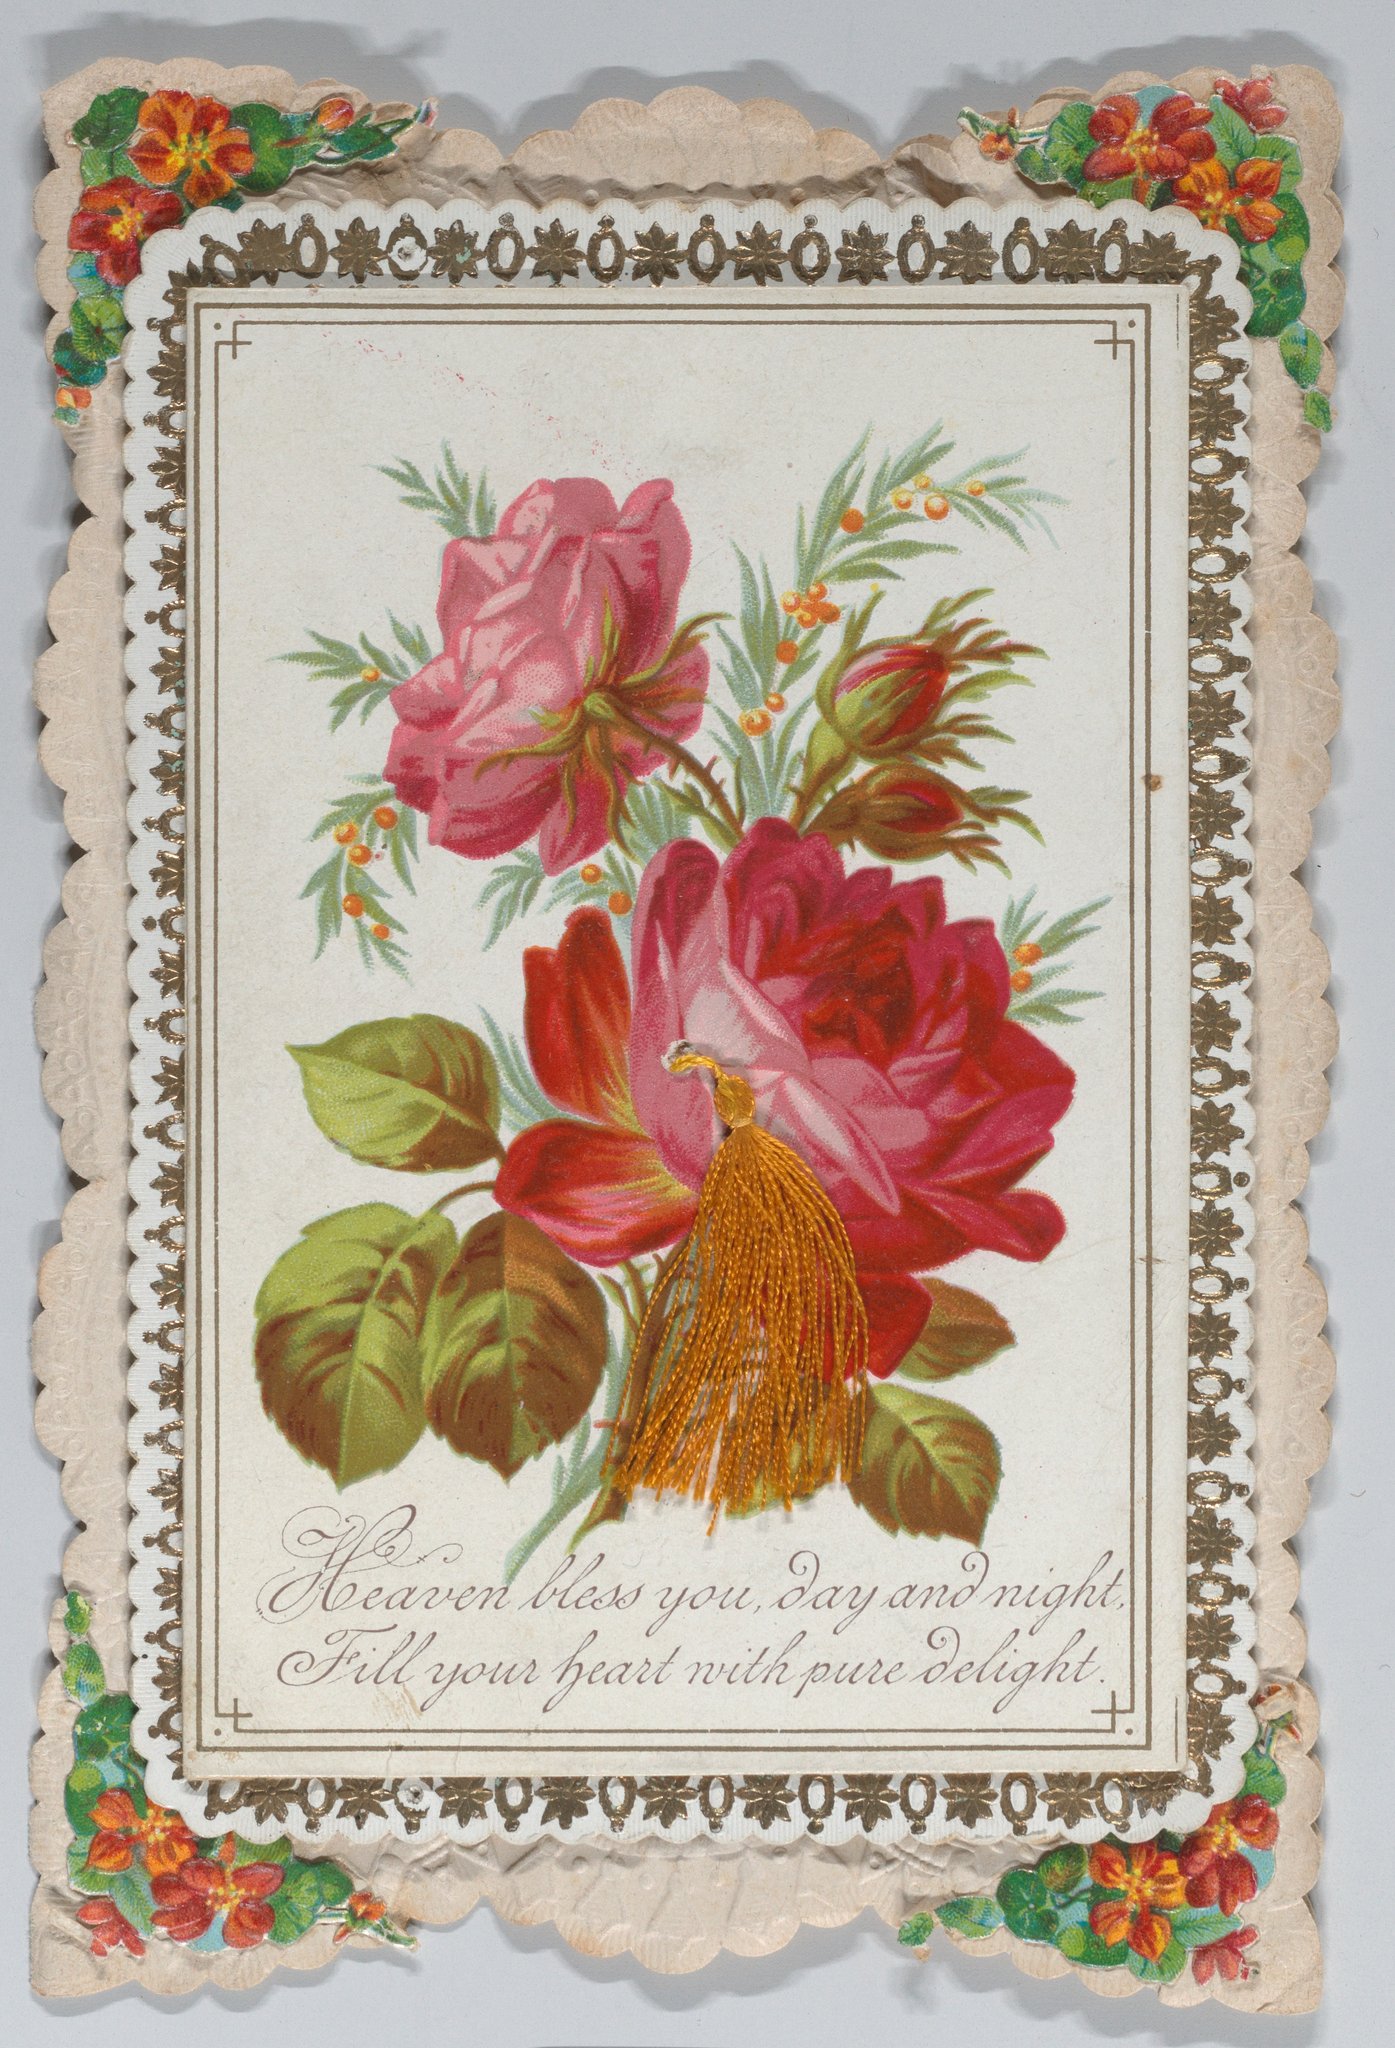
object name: valentine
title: Valentine - Mechanical - pulls open to reveal elaborate scene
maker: anonymous, british, 19th century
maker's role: artist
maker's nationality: british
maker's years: 1800-1900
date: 1875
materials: paper, silk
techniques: chromolithography, cutting, embossing, gilding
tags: flowers